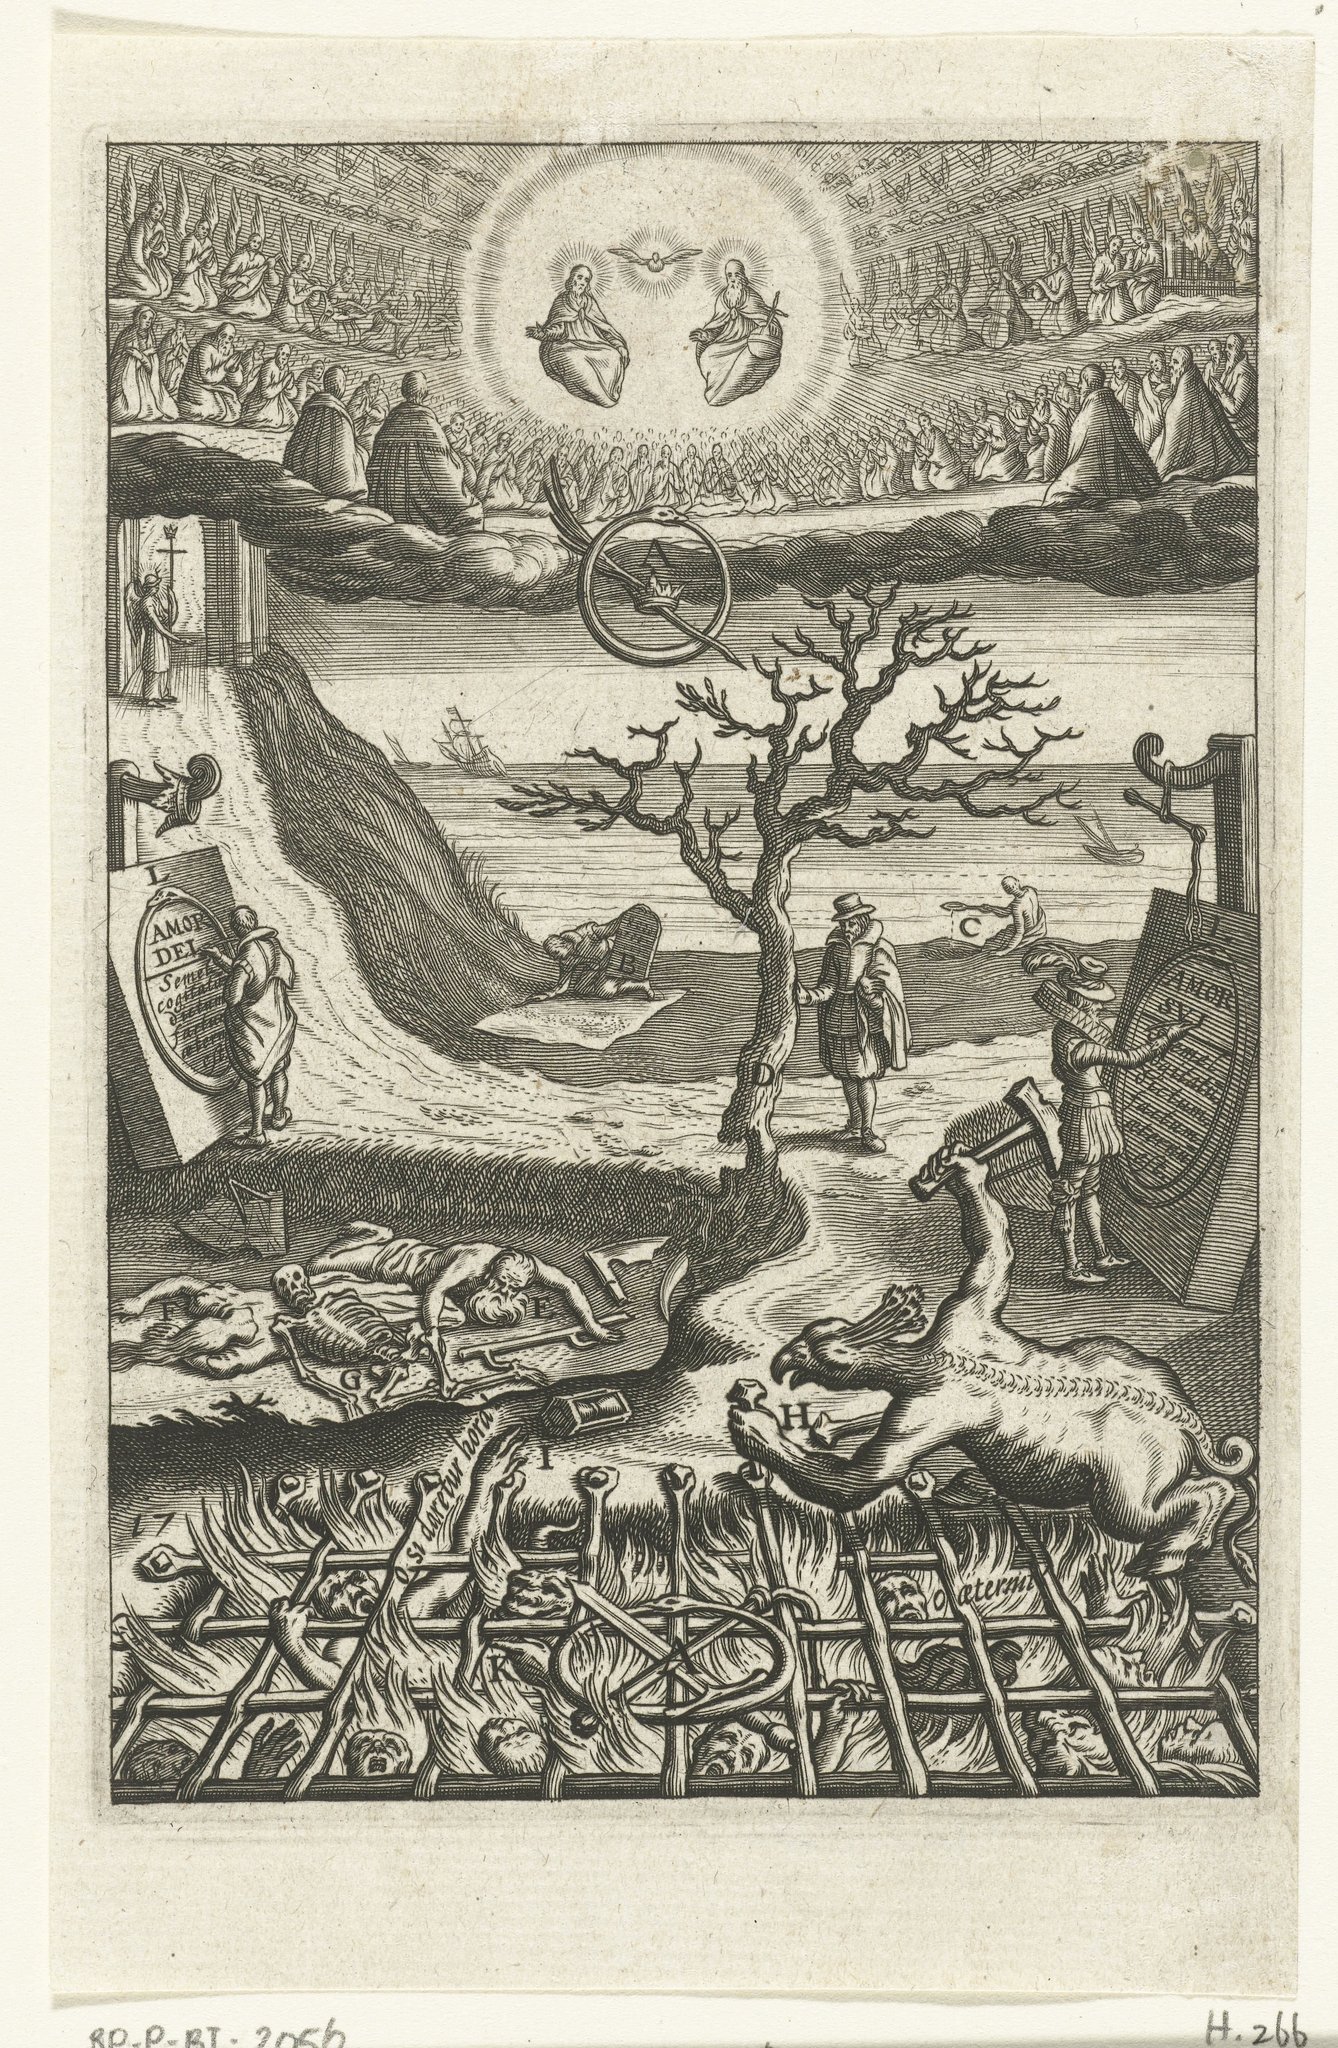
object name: book illustration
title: Den wech des eeuwich levens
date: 1620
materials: paper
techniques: engraving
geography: antwerp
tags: the life of man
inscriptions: collector's mark: Lugt 2228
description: Een man twijfelt over zijn levenswandel bij een splitsing van twee wegen. De ene weg van een leven in deugd leidt naar de eeuwigheid en de andere weg van een leven in zonde leidt naar de hel. Hij moet overwegen of hij spijt krijgt van zijn keuze na zijn dood, aldus het meditatievoorschrift in de uitgave.